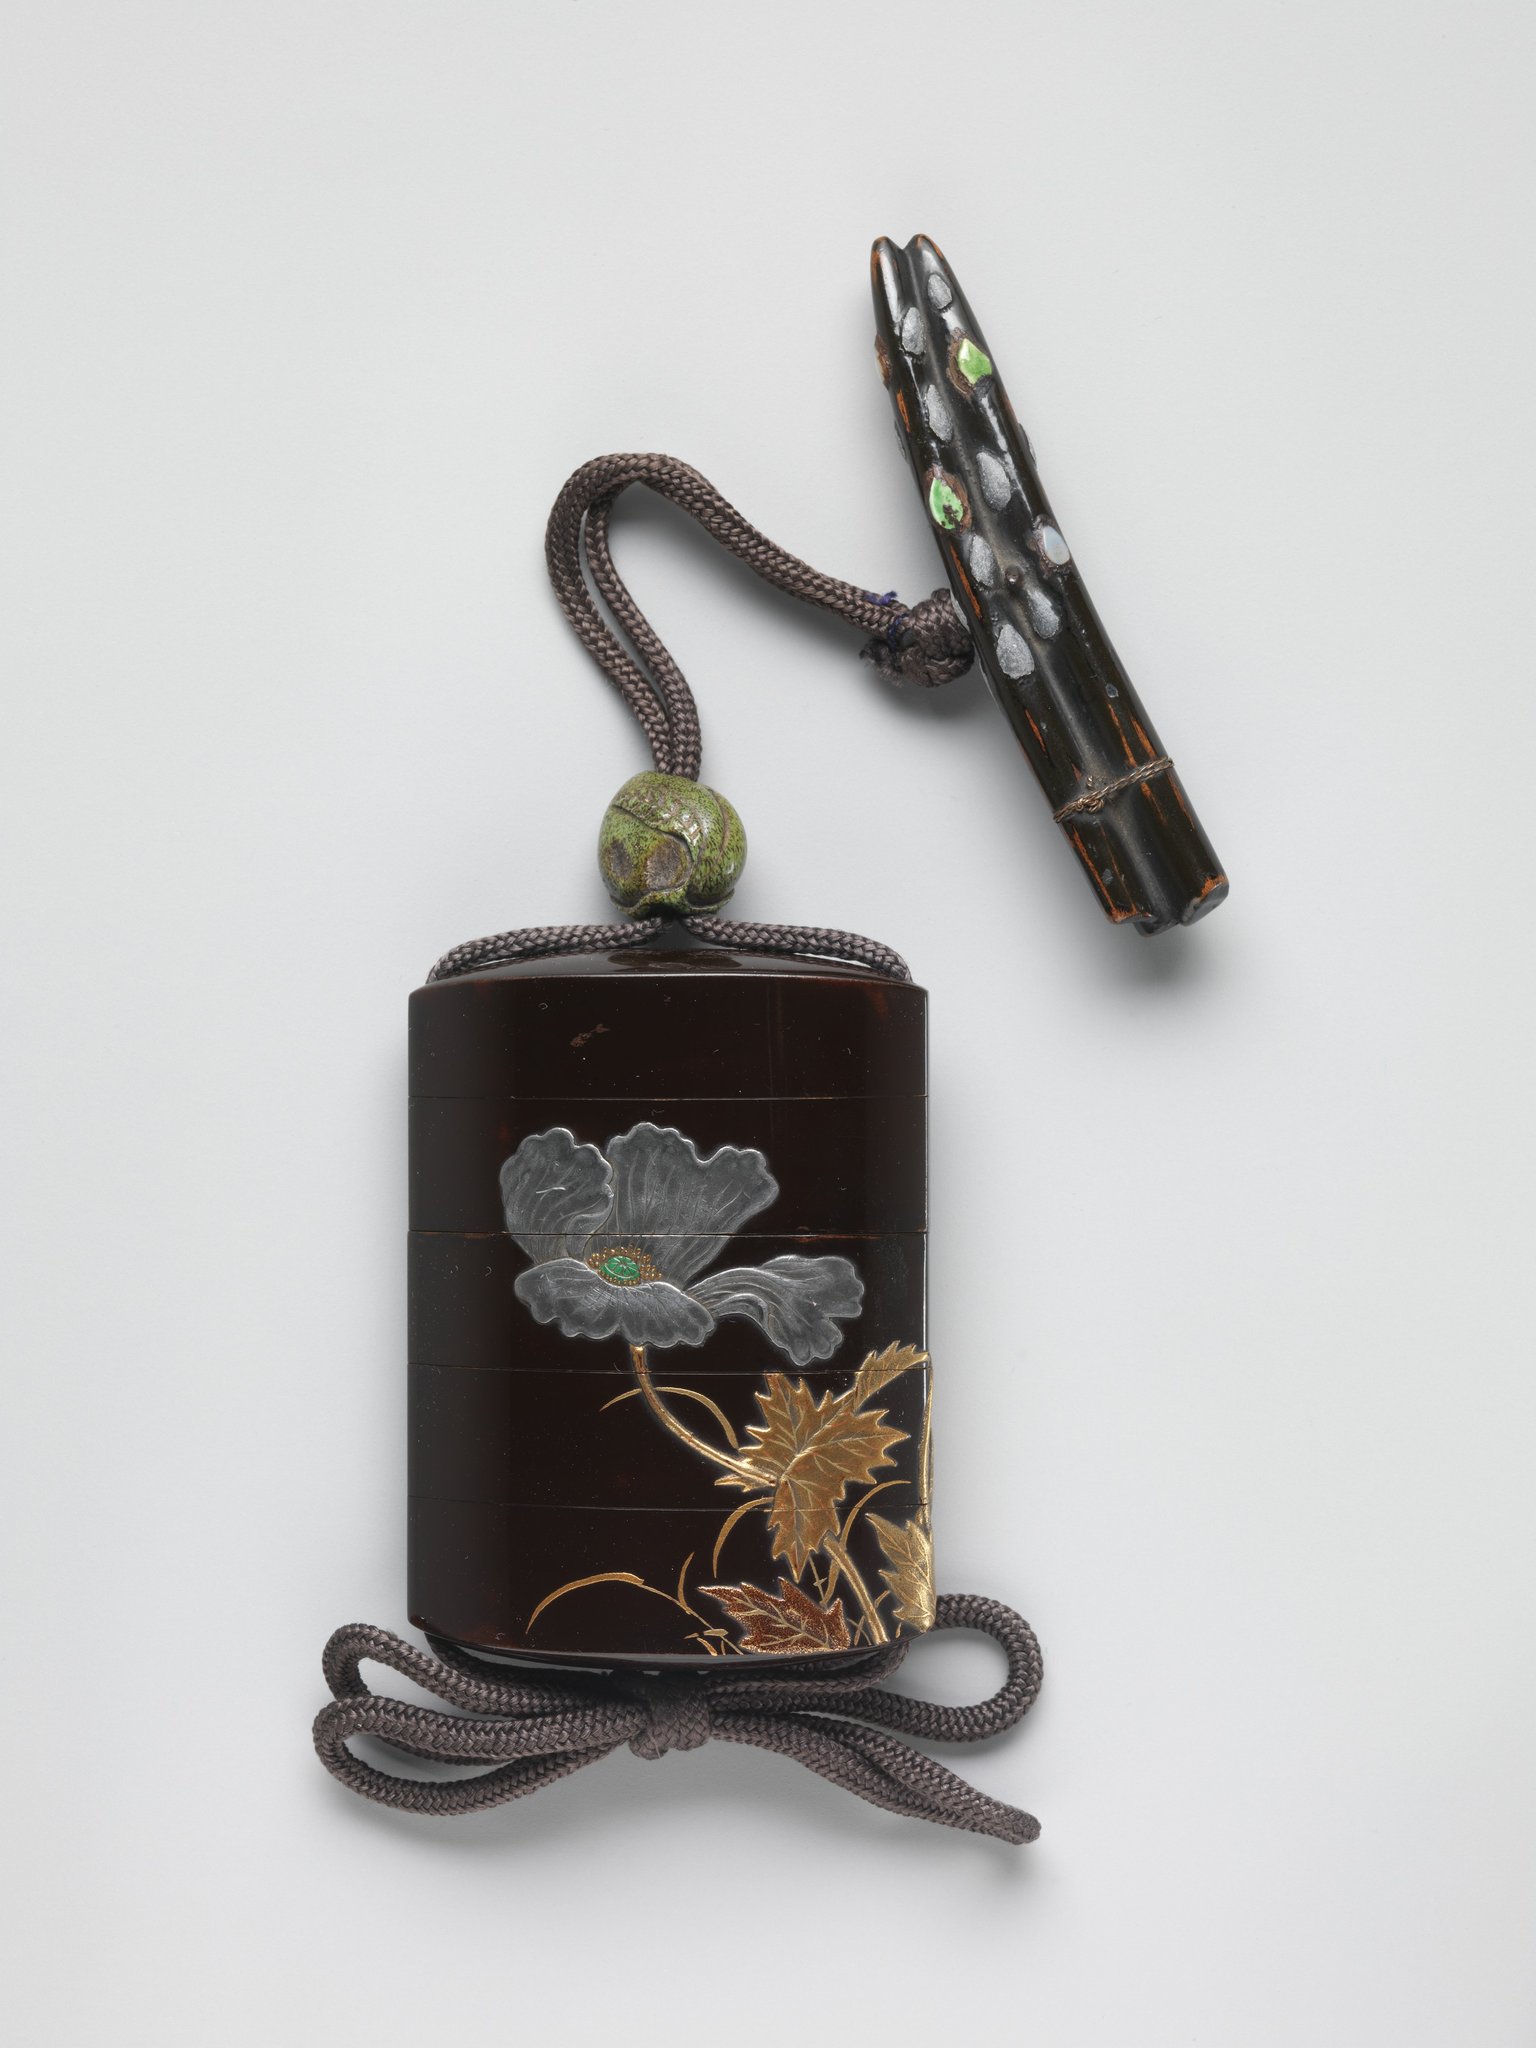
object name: inrō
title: Case (Inrō) with Design of Poppies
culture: japanese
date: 1615-1868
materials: ceramic, gold, lacquer, metal, pewter, wood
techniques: carving, incising, inlay, maki, stain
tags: poppies